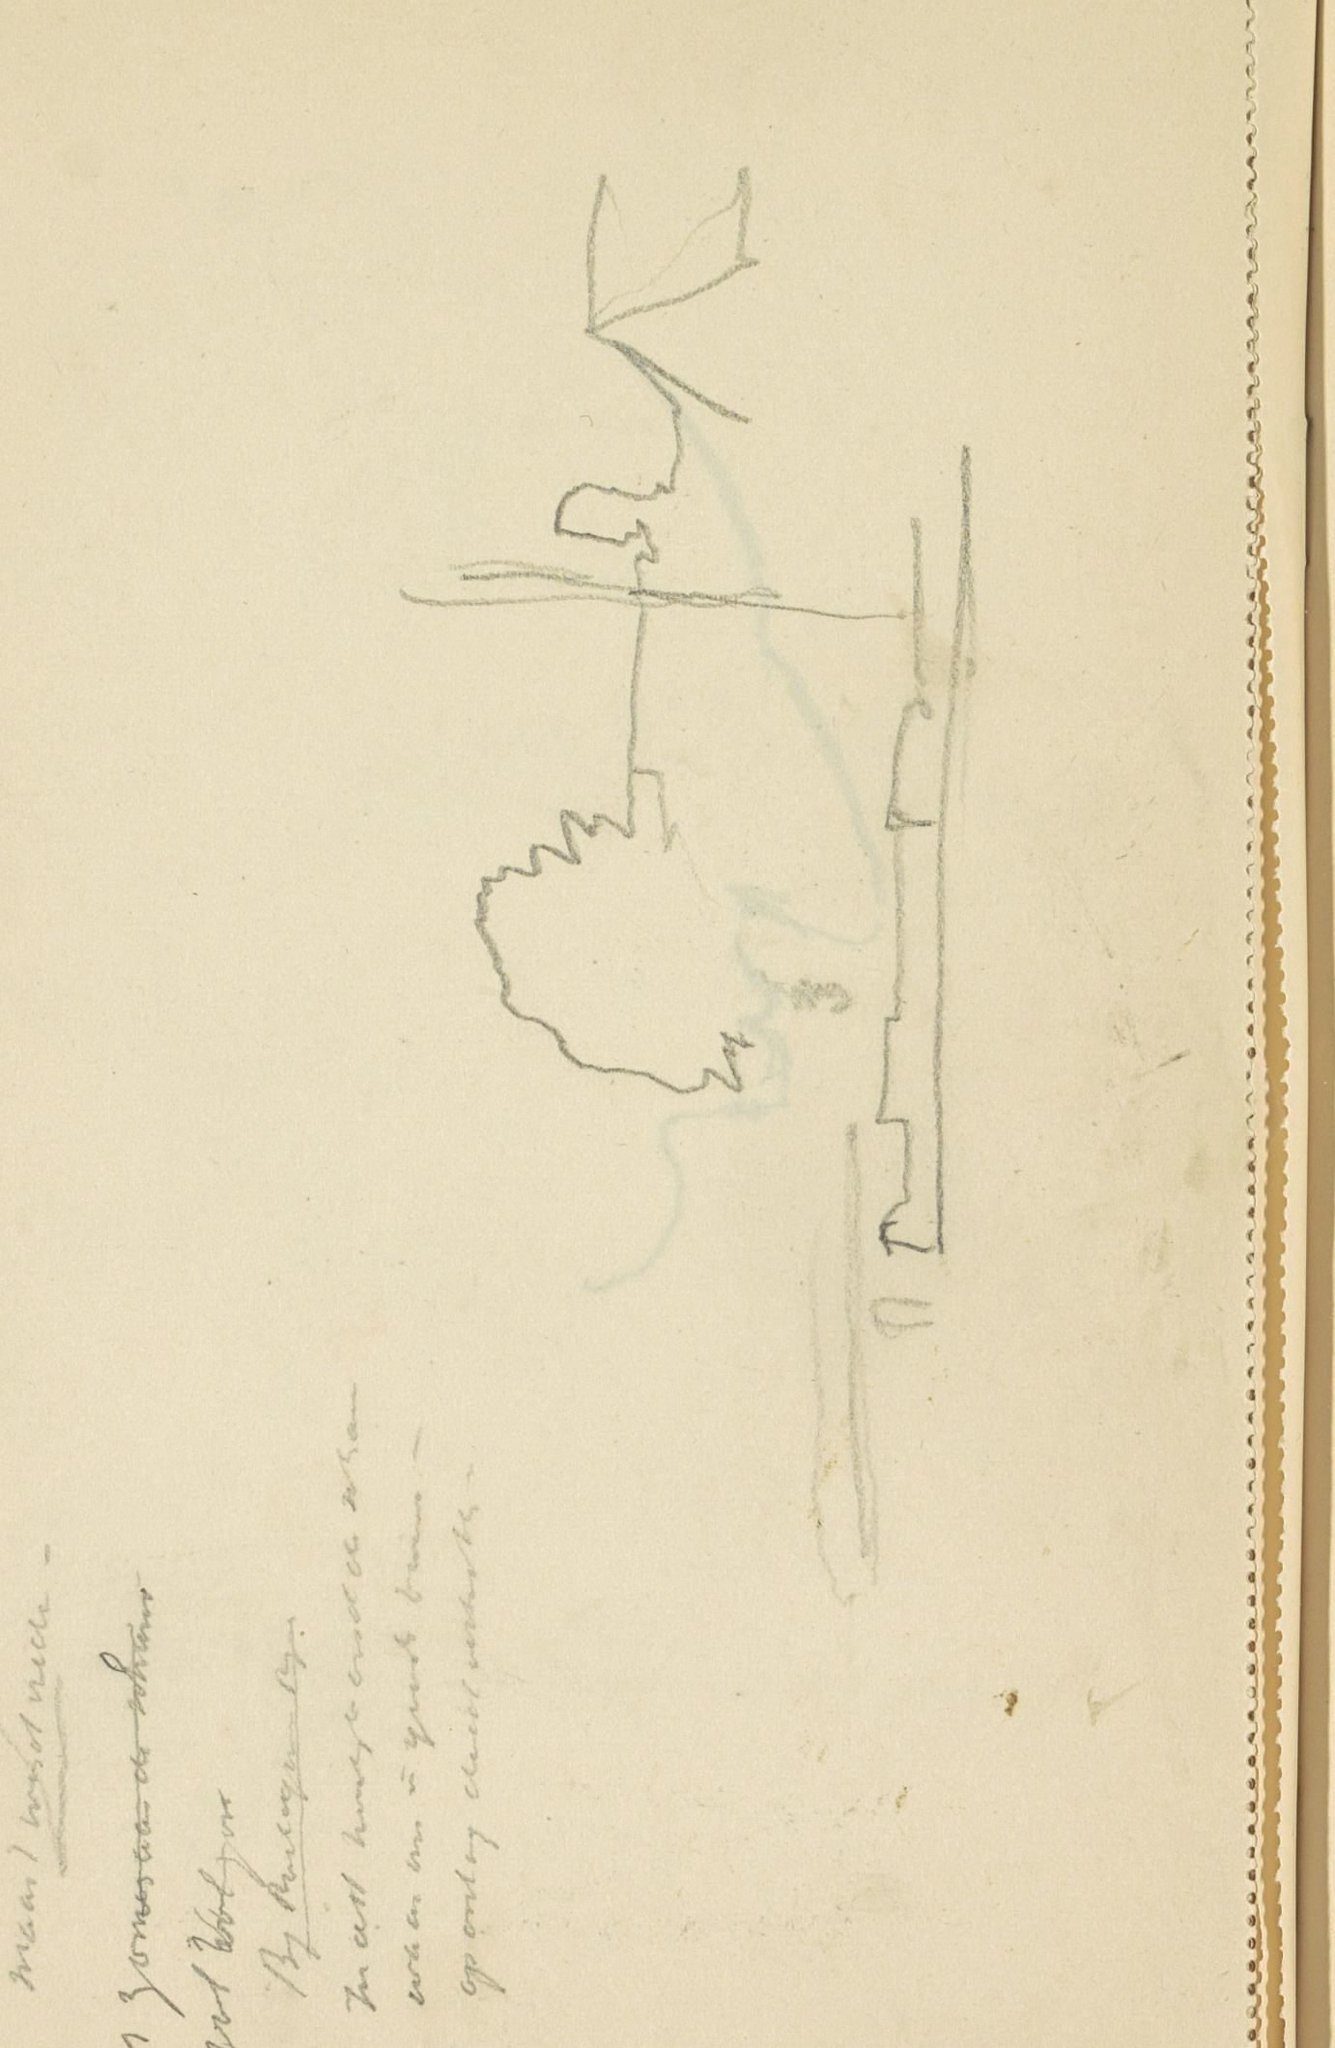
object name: sketchbook leaf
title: Boom naast een huis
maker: cornelis vreedenburgh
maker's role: draughtsman, print maker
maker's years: 1880-1946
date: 1890-1946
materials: paper, pencil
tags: trees, housing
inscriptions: annotation: ‘N zomer aan de schans/ [...]waar [...] goeds/ op on[...] deed verkorte’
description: Blad 48 verso uit een schetsboek met 73 bladen.